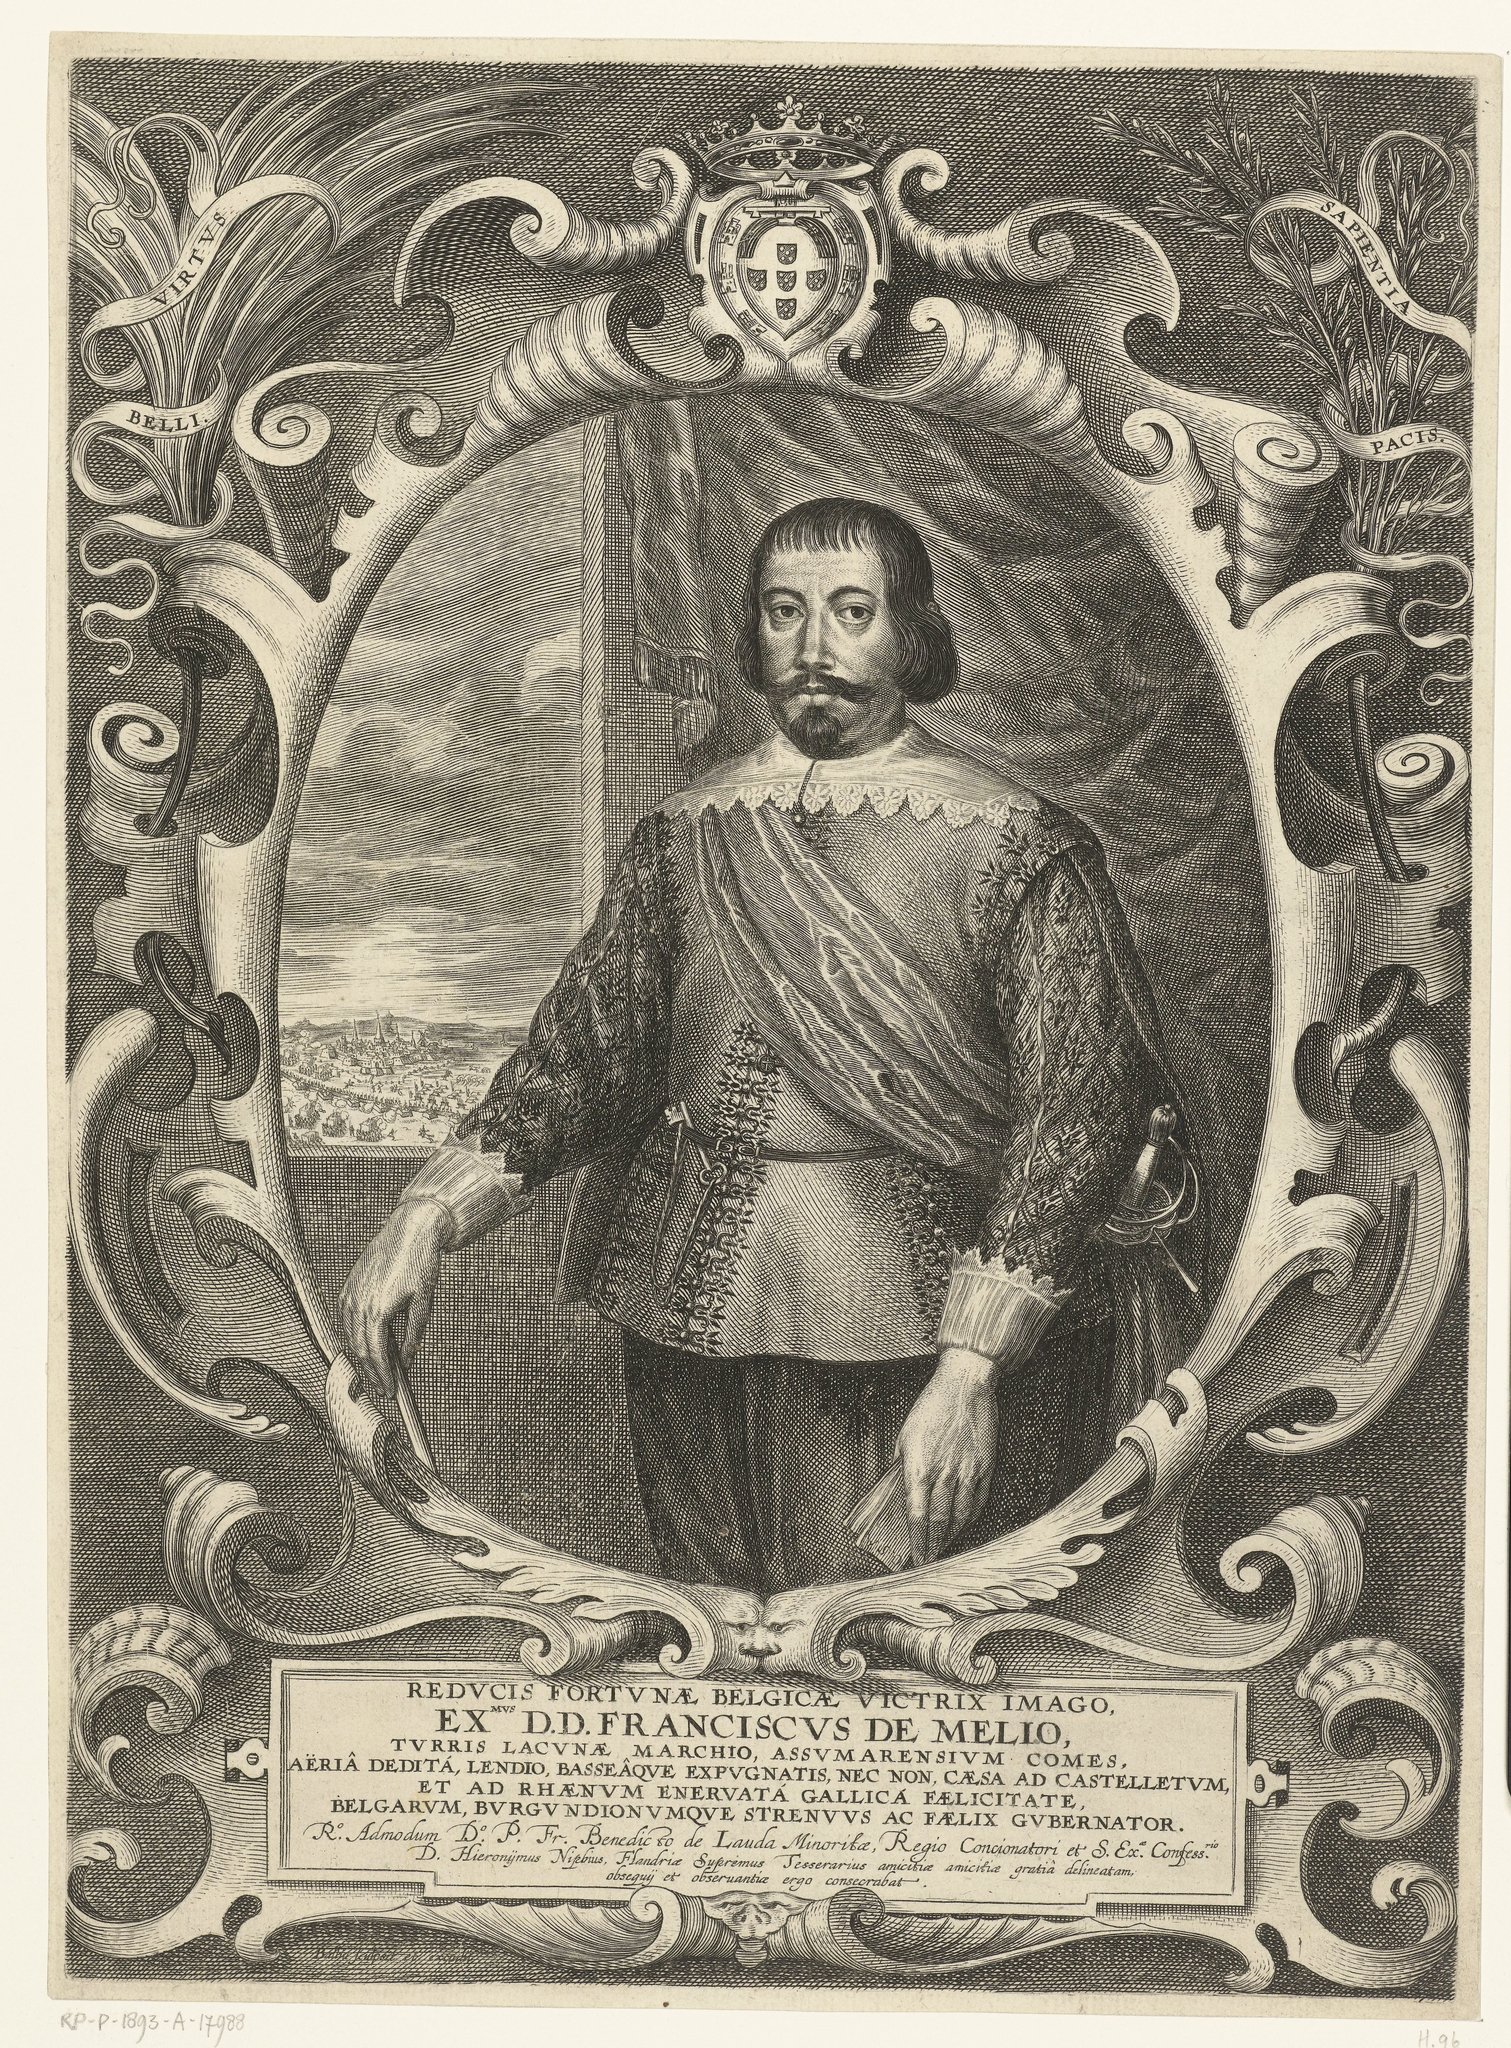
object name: print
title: Redvcis fortunae Belgicae (...) ac faelix gvbernator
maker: pieter de bailliu (i)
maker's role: print maker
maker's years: 1613-1660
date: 1623-1660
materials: paper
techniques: engraving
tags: francisco de melo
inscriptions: collector's mark: Lugt 2228